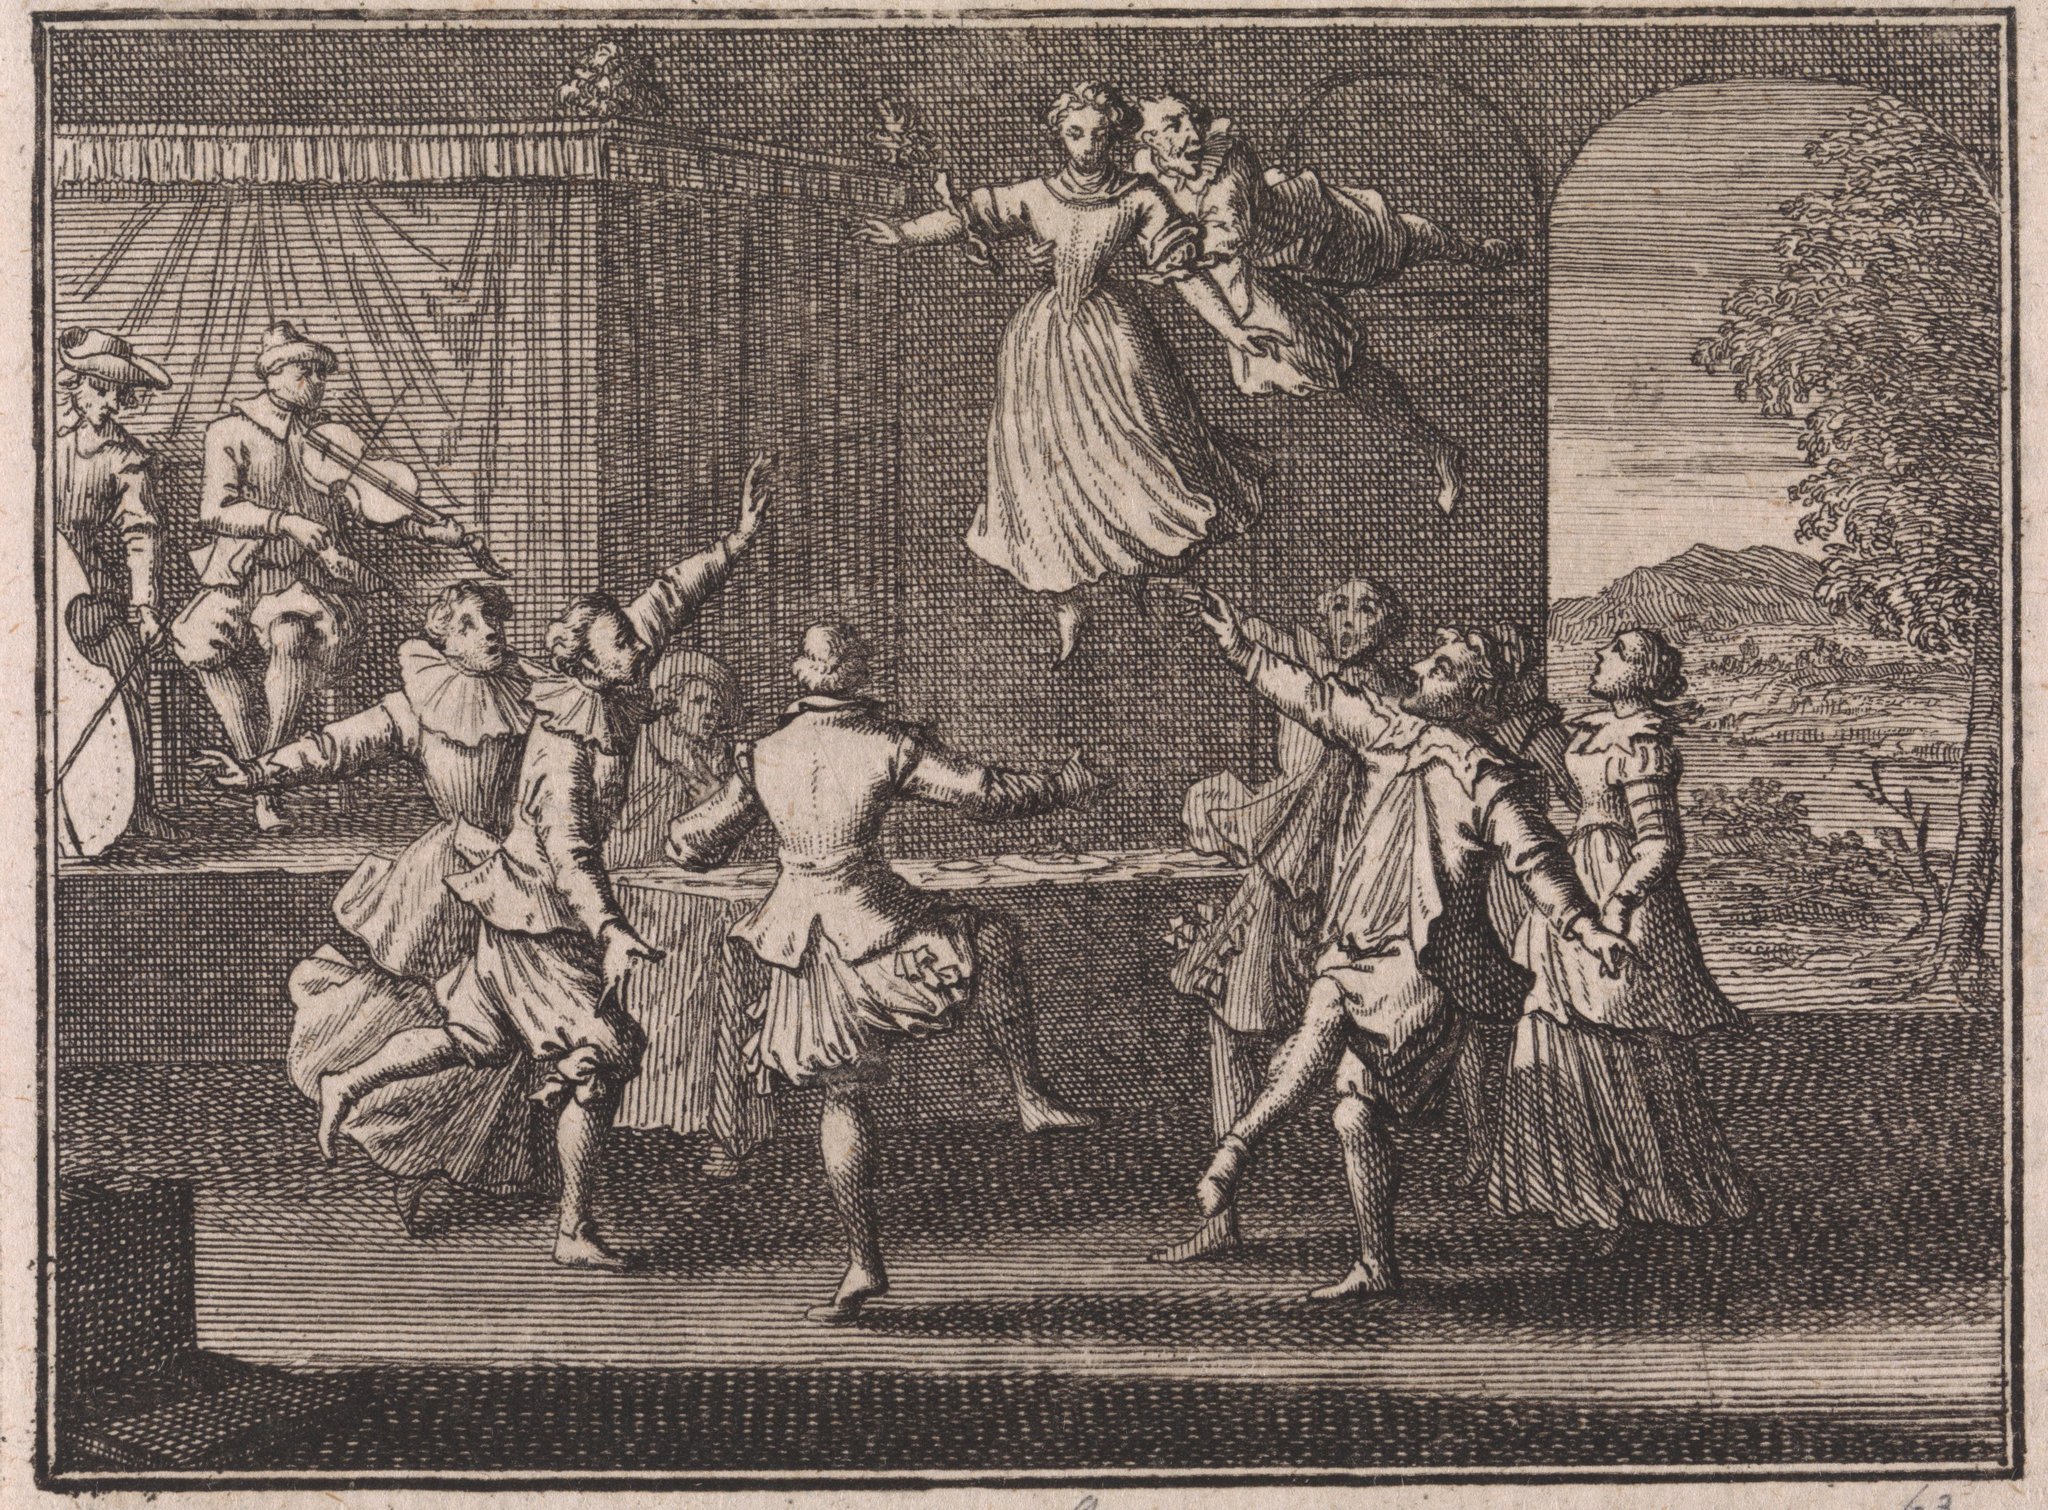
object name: print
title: The Unfaithful Bride Abducted by the Devil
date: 1704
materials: paper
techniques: engraving, etching, letterpress printing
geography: nuremberg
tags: bad wife, dancing at wedding feast, devil or demons attacking mortals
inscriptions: collector's mark: Lugt 2228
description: An unfaithful woman can always be caught up by her past misconduct, even in the middle of her own wedding banquet. Here, the adulterous bride is taken away by the devil, while the guests, interrupting their dance, stand in awe at this unearthly vision. The scene is taken from an illustrated anthology of peculiar stories with a moralizing tone published in Germany in 1704.